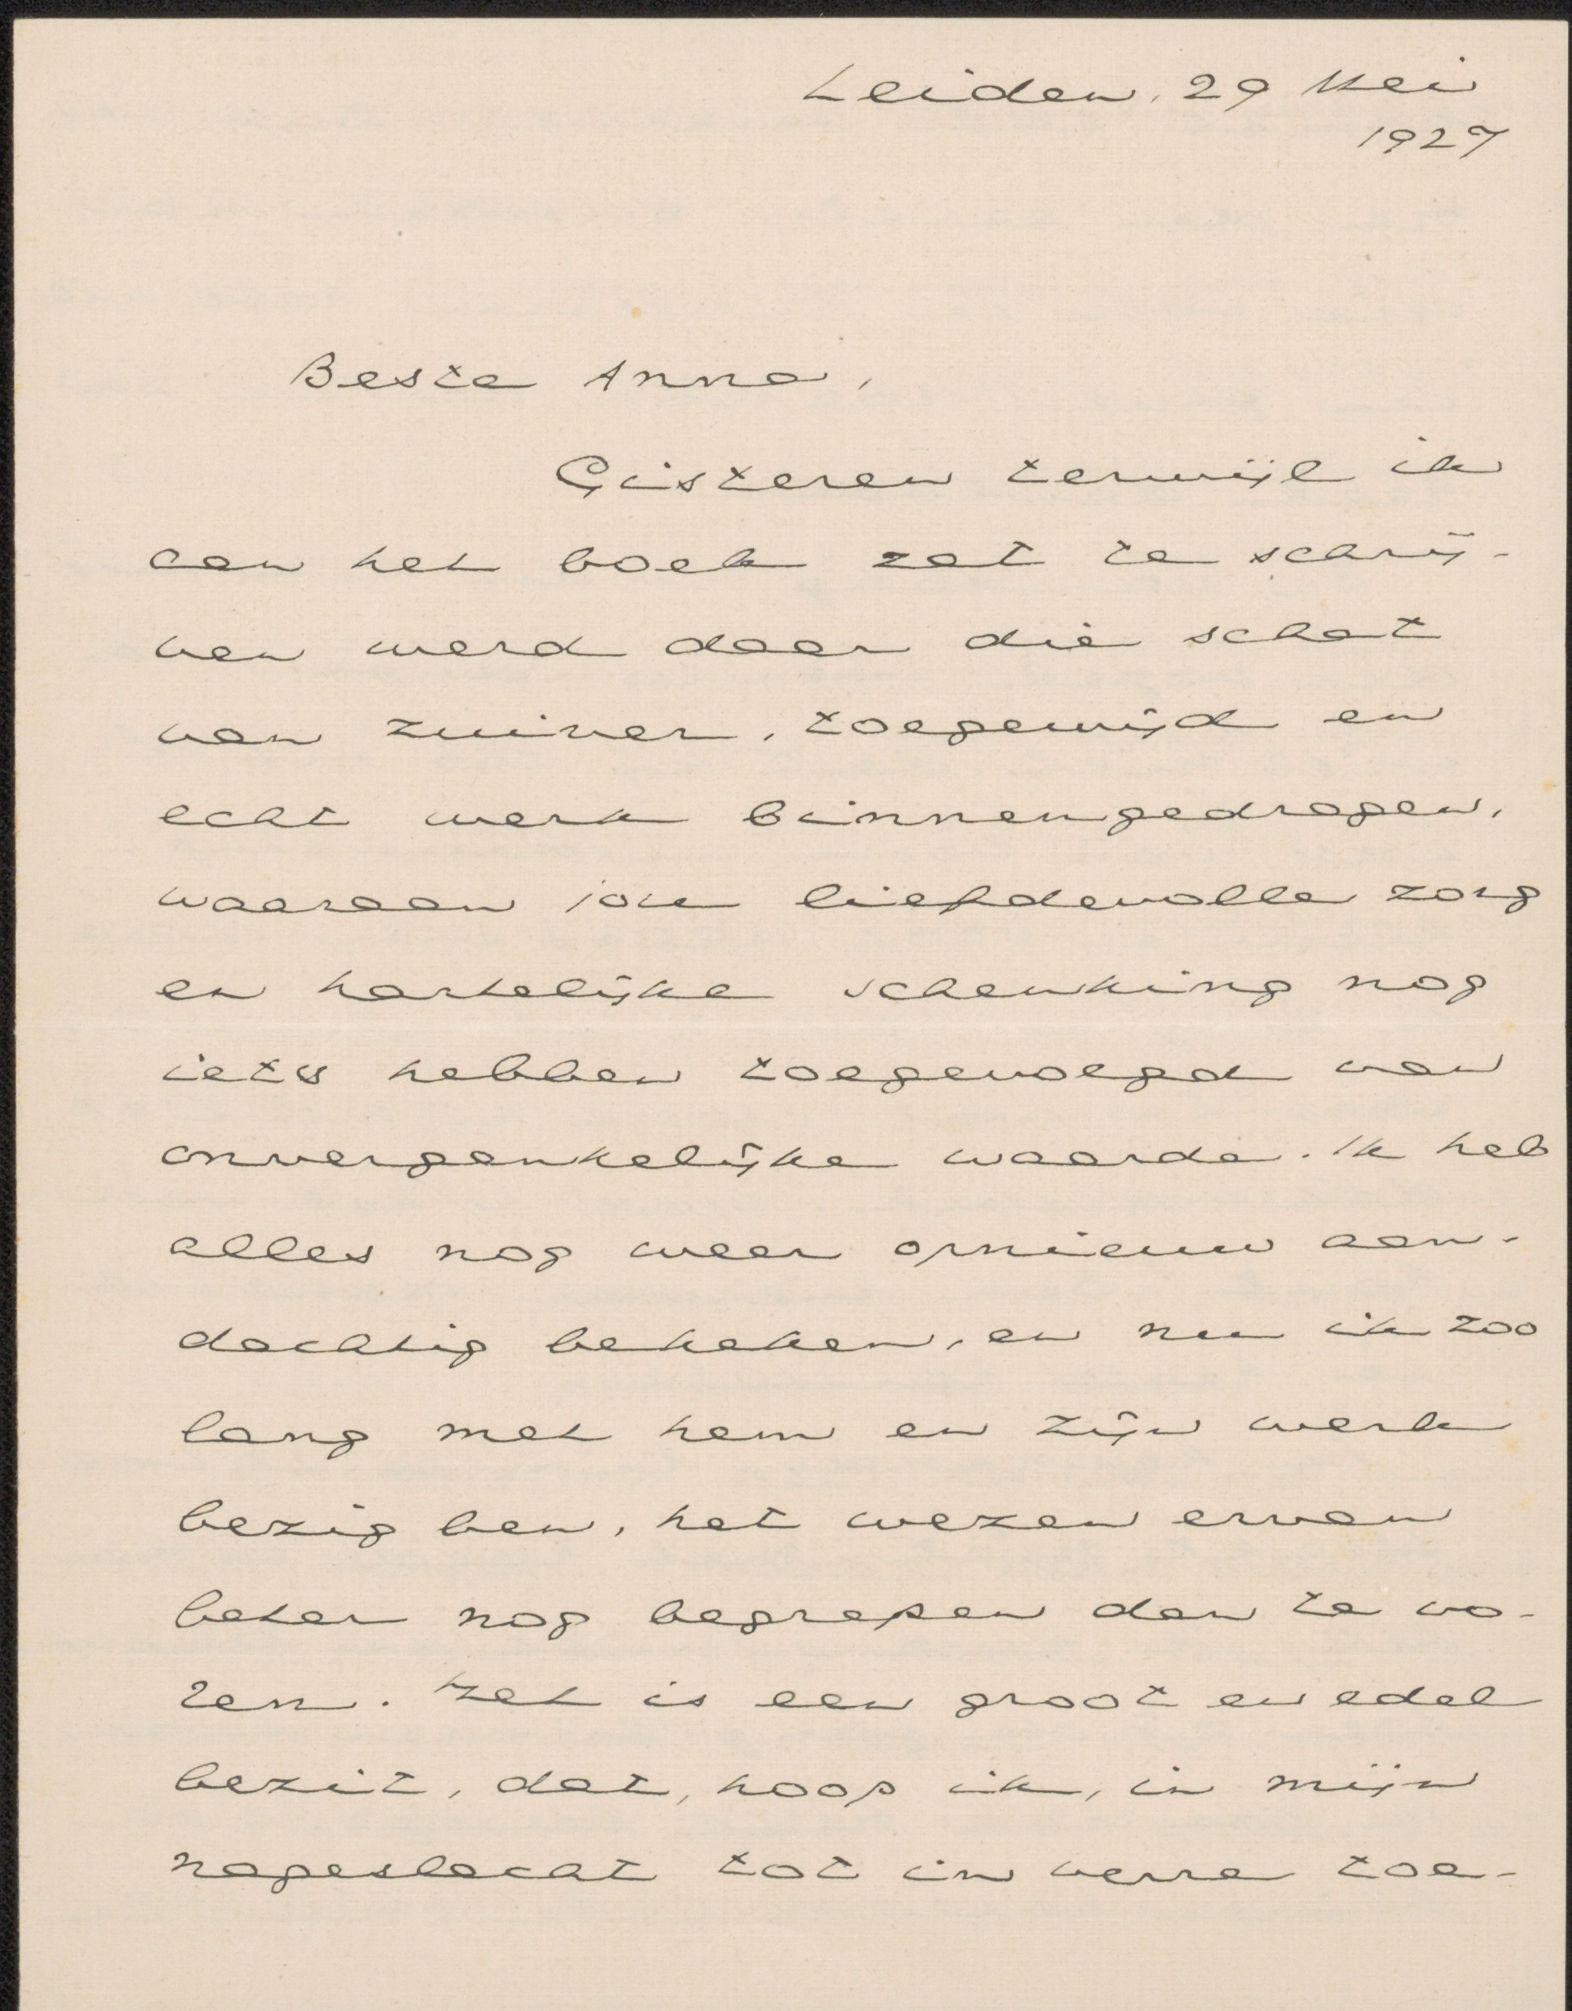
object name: letter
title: Brief aan Anna Dorothea Dirks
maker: johan huizinga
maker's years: 1872-1945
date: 1927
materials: ink, paper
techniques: pen, writing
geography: leiden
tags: printer, artist, anna dorothea dirks, haarlem, hermanus diedericus tjeenk willink (1843-1917), the graphic arts, illustration ~ printed matter, book, leiden, amsterdam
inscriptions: collector's mark: ‘RPK’